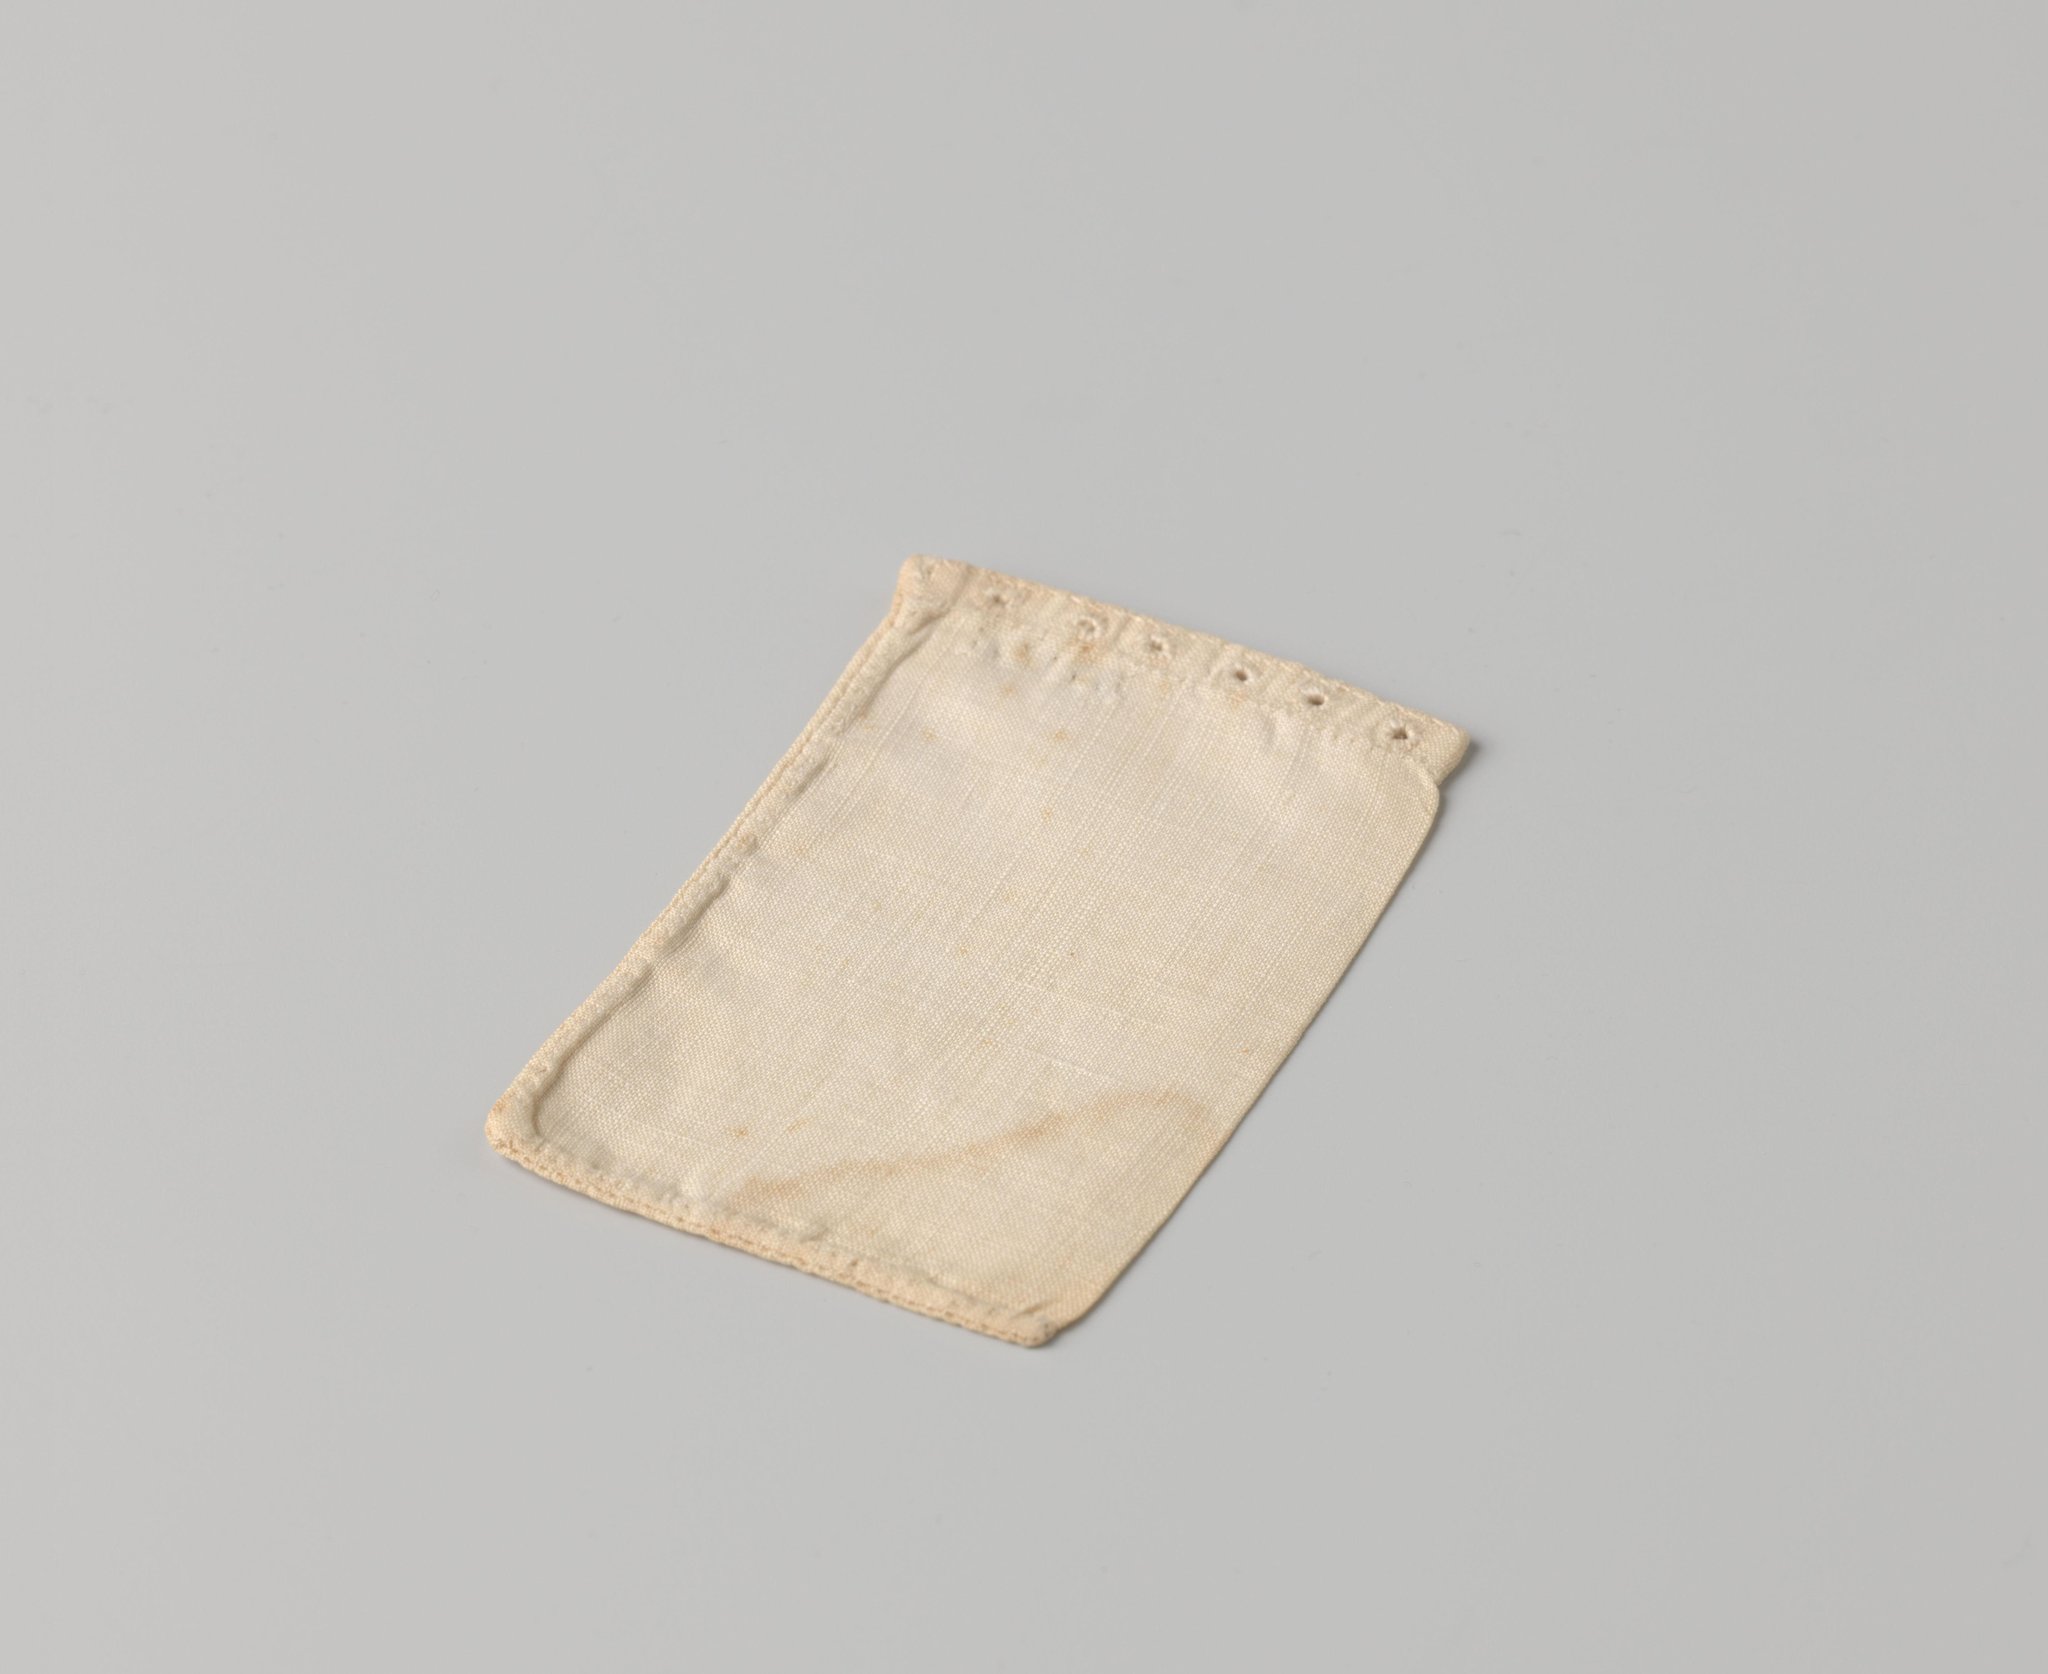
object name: sloop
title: Sloop met koordsluiting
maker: Anonymous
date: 1750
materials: linen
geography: netherlands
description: Sloop voor kussen, aan korte zijde voorzien van zes gaten voor koordsluiting.